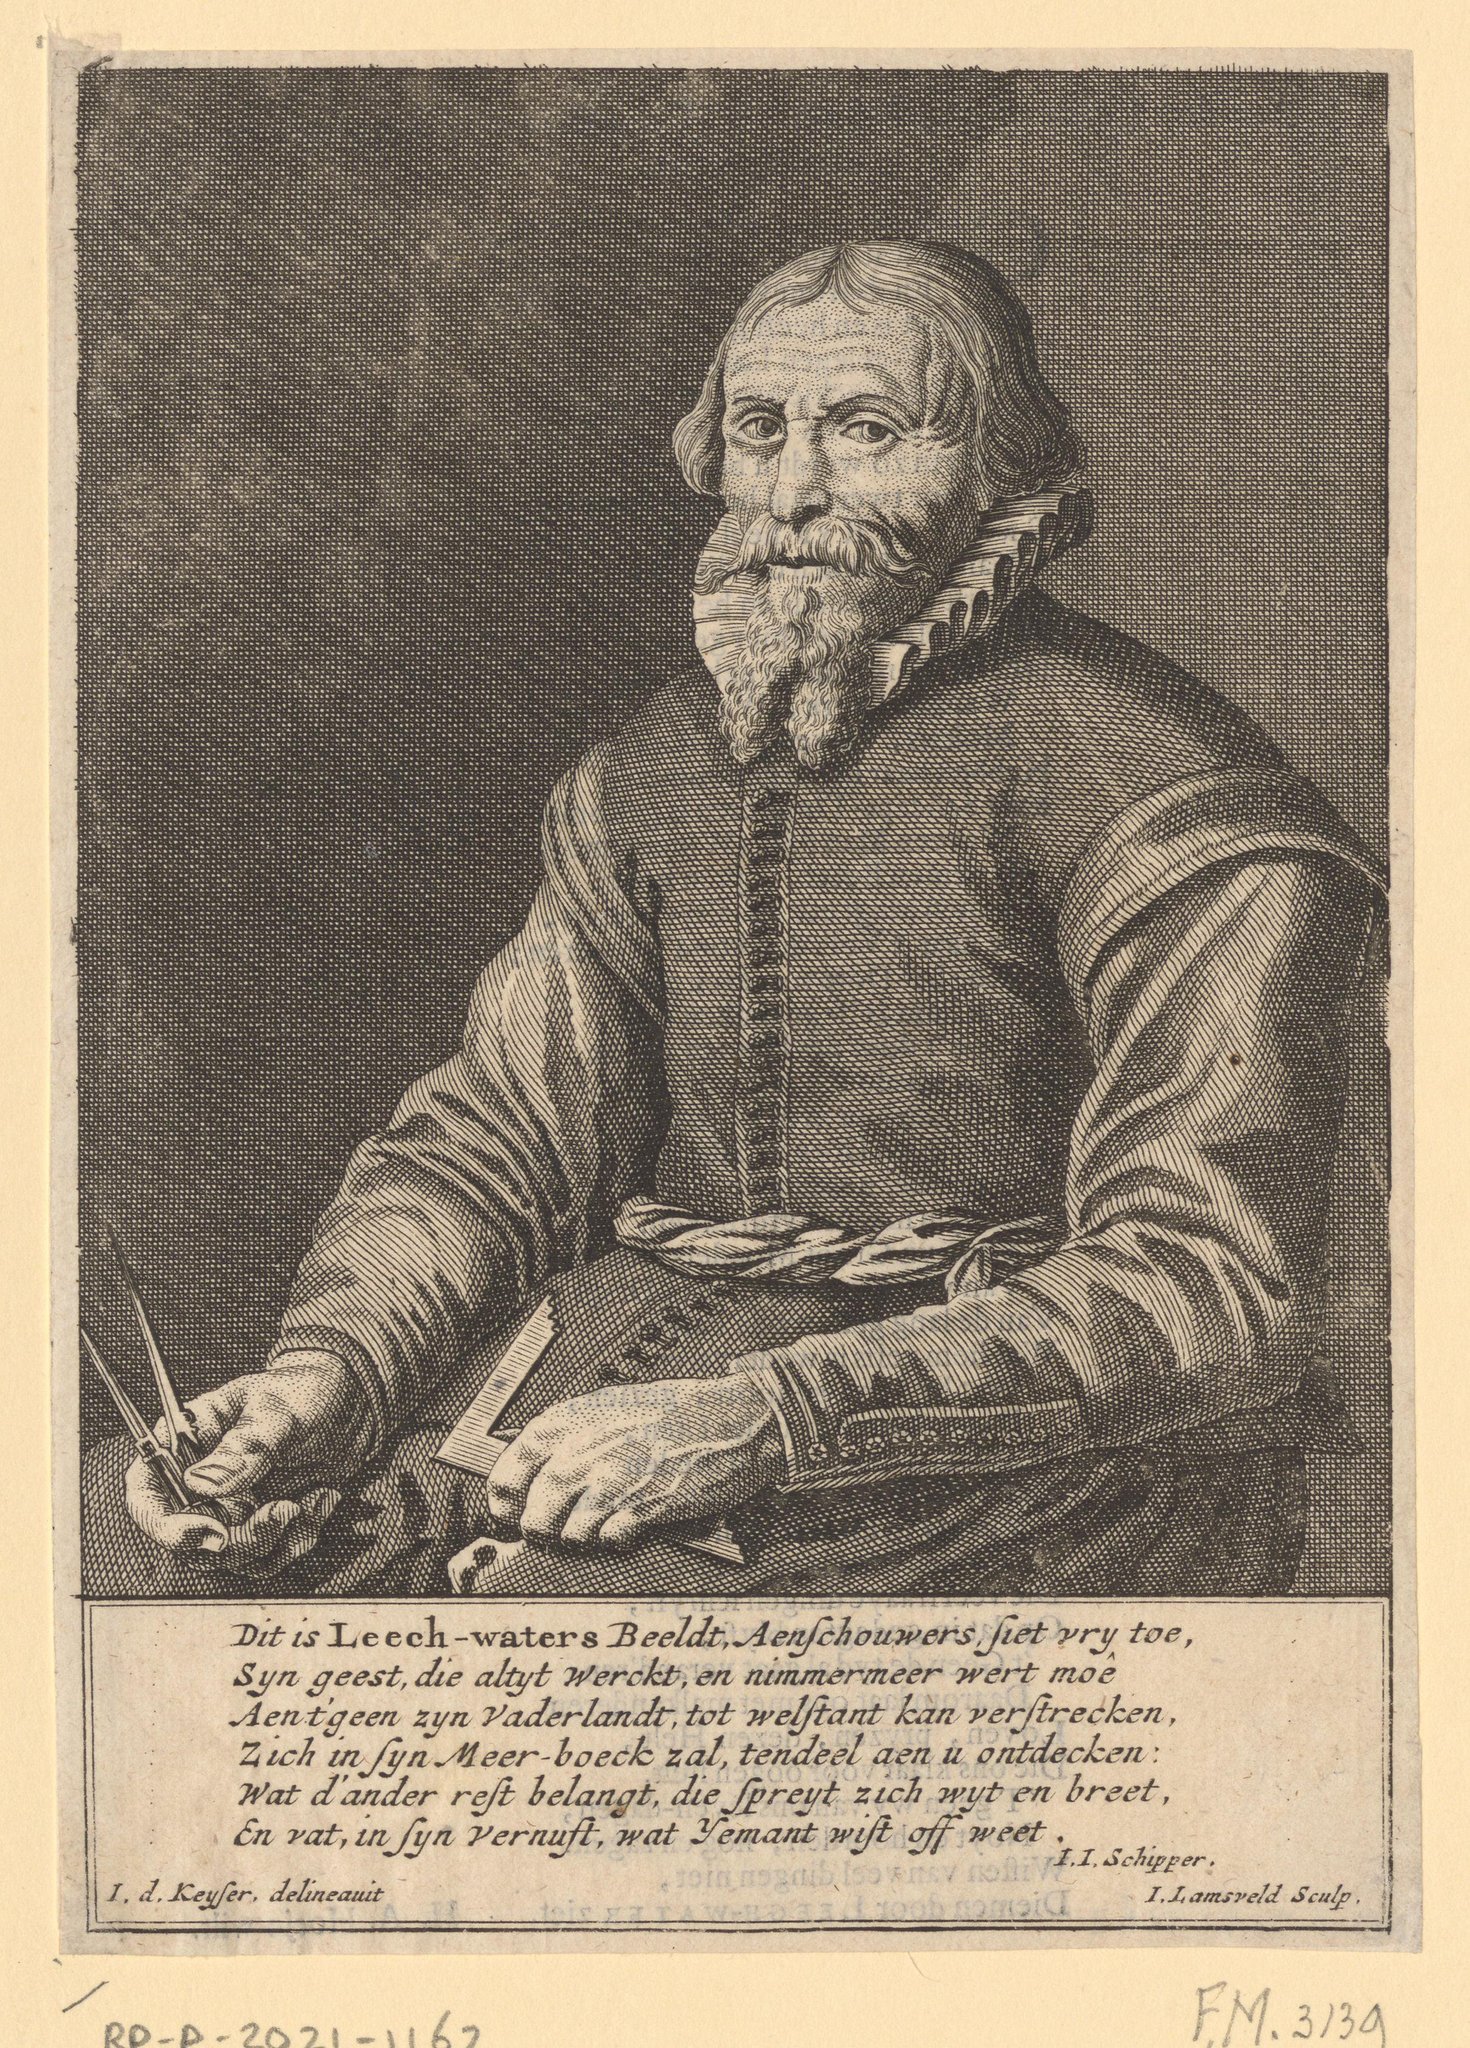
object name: book illustration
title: Portret van Jan Adriaensz. Leeghwater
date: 1714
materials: paper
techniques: etching, letterpress printing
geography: amsterdam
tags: amsterdam, jan adriaensz. leeghwater, fluid mechanics, hydraulics, historical persons, compasses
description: Prent waarschijnlijk uit: Leeghwater, Jan Adriaensz. Haarlemmer-Meer-Boeck (...). Amsterdam: Pieter Visser, Jan van Heekeren en Jan Graal, 1714. De prent is ook (met andere tekst op verso) gebruikt in de edities van Haarlemmer-Meer-Boek uit 1724, 1727 en 1764. Het gedicht van Hendrik Albertsz. Hoejewilt op het verso wordt ook gevonden in: Leeghwater, Jan Adriaensz. Een kleyn Cronykje ende Voorbereydinge van de Afkomste ende 't vergroten van de Dorpen van Graft en Ryp (...). Amsterdam: Pieter Visser, 1727. En in de editie van 1736 en 1764. Mogelijk is het portret ook in een druk van 'Een kleyn Cronykje' gebruikt.